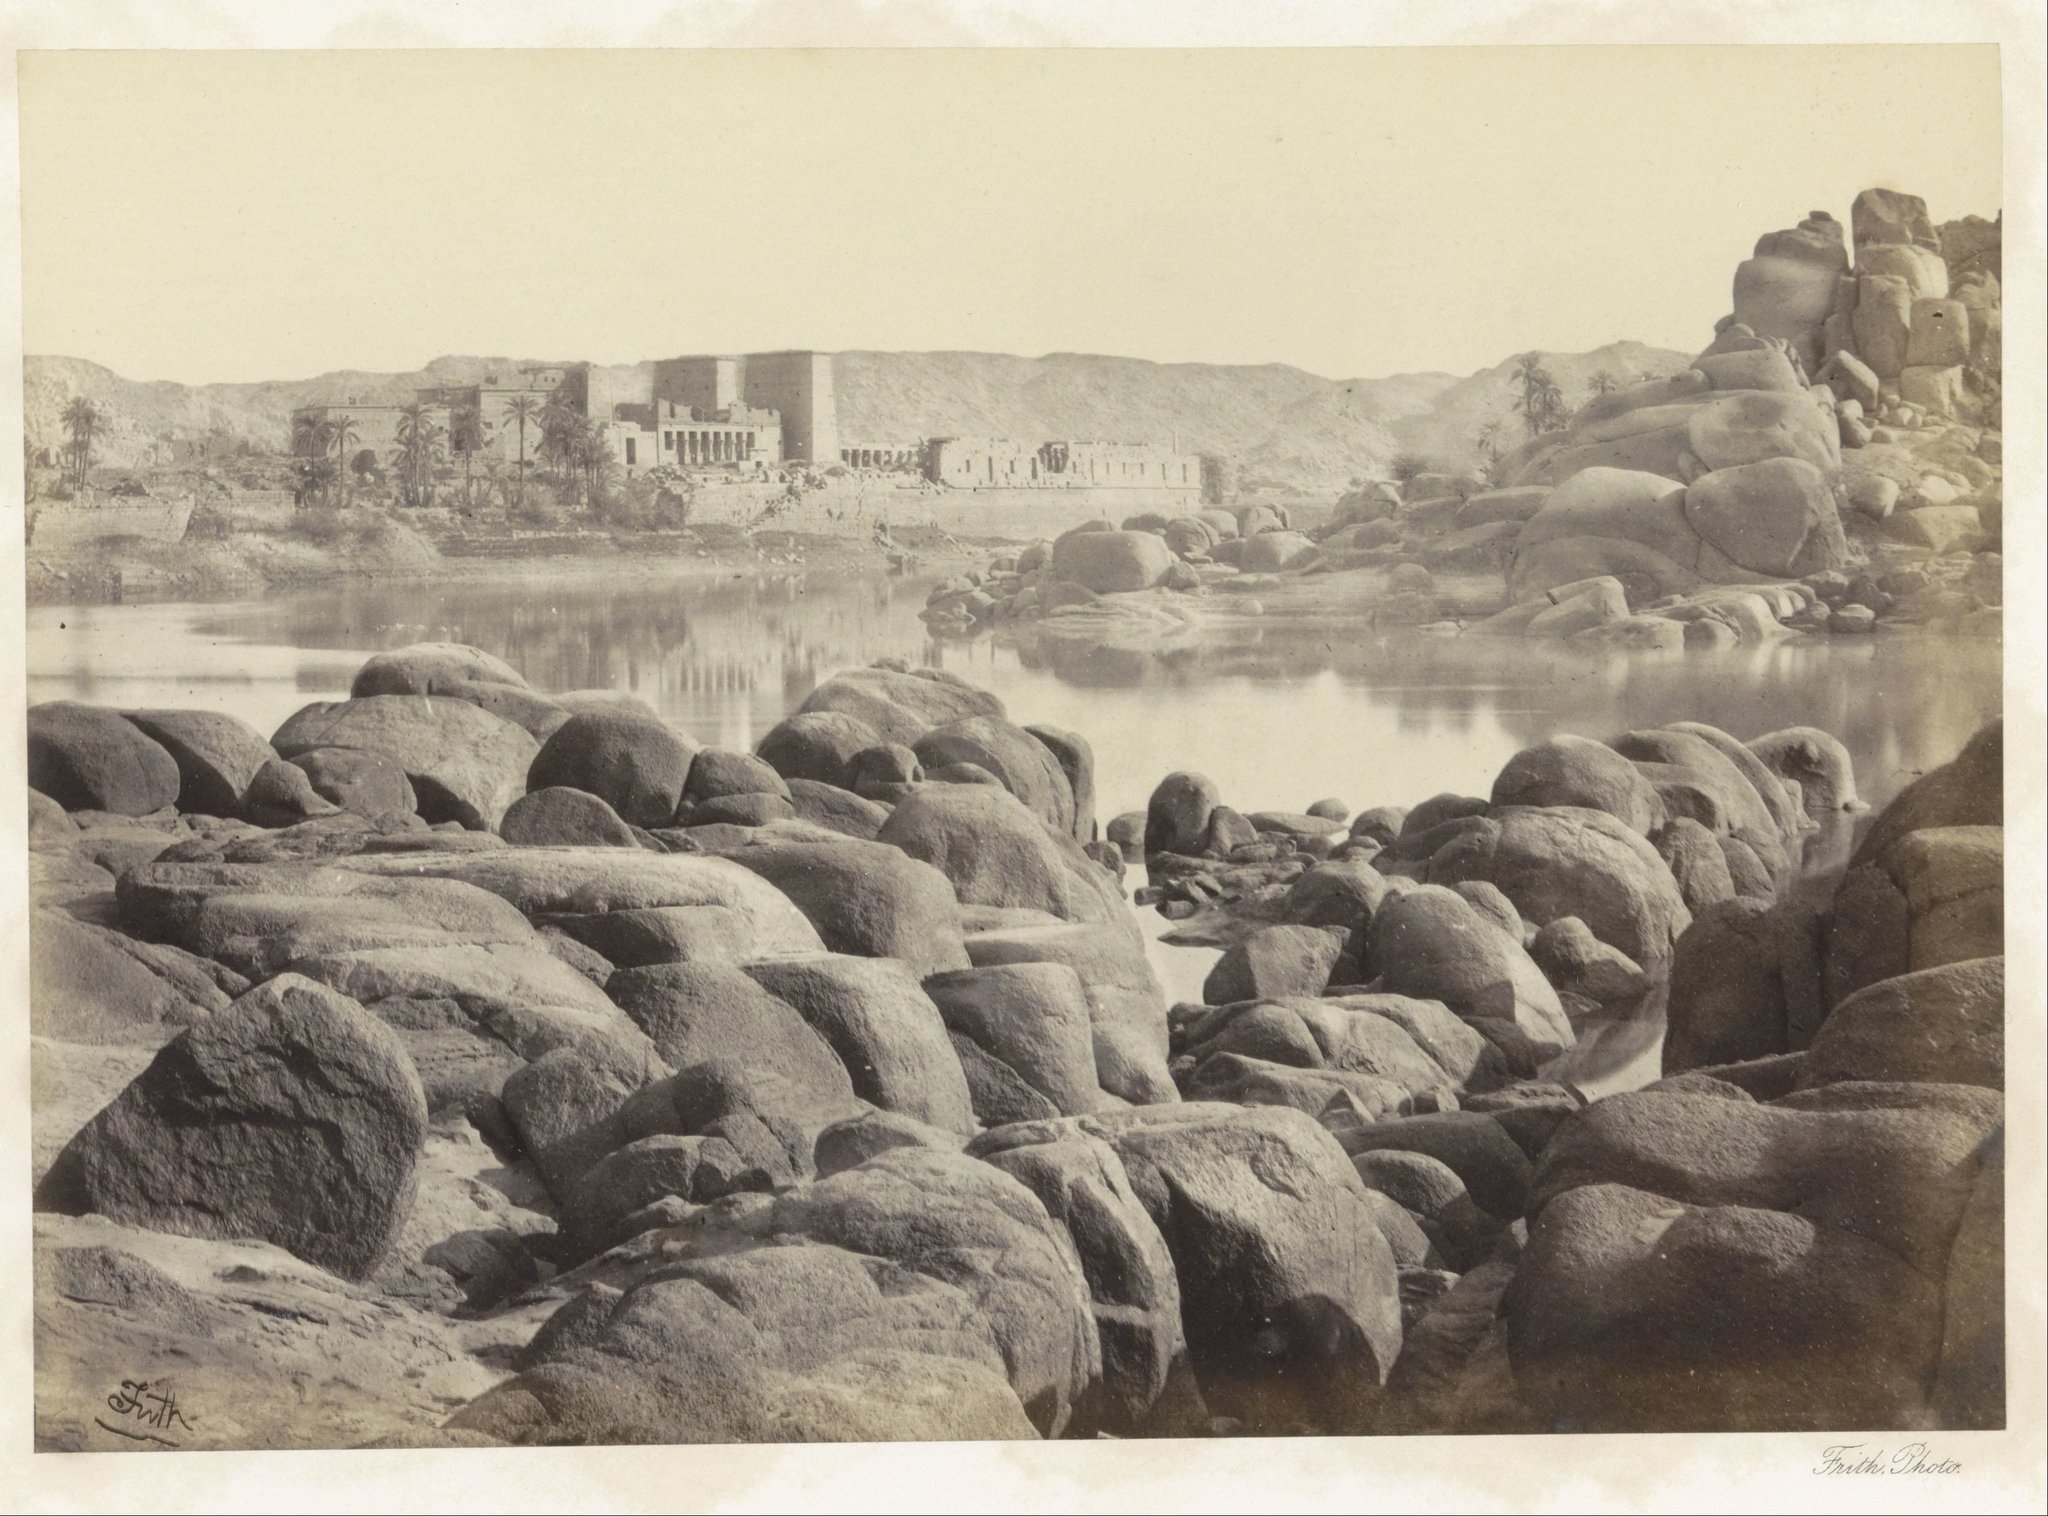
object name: page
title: The approach to Philae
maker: francis frith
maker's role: publisher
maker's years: 1822-1898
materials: paper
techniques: albumen print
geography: philae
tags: island, temple, shrine ~ egyptian religion